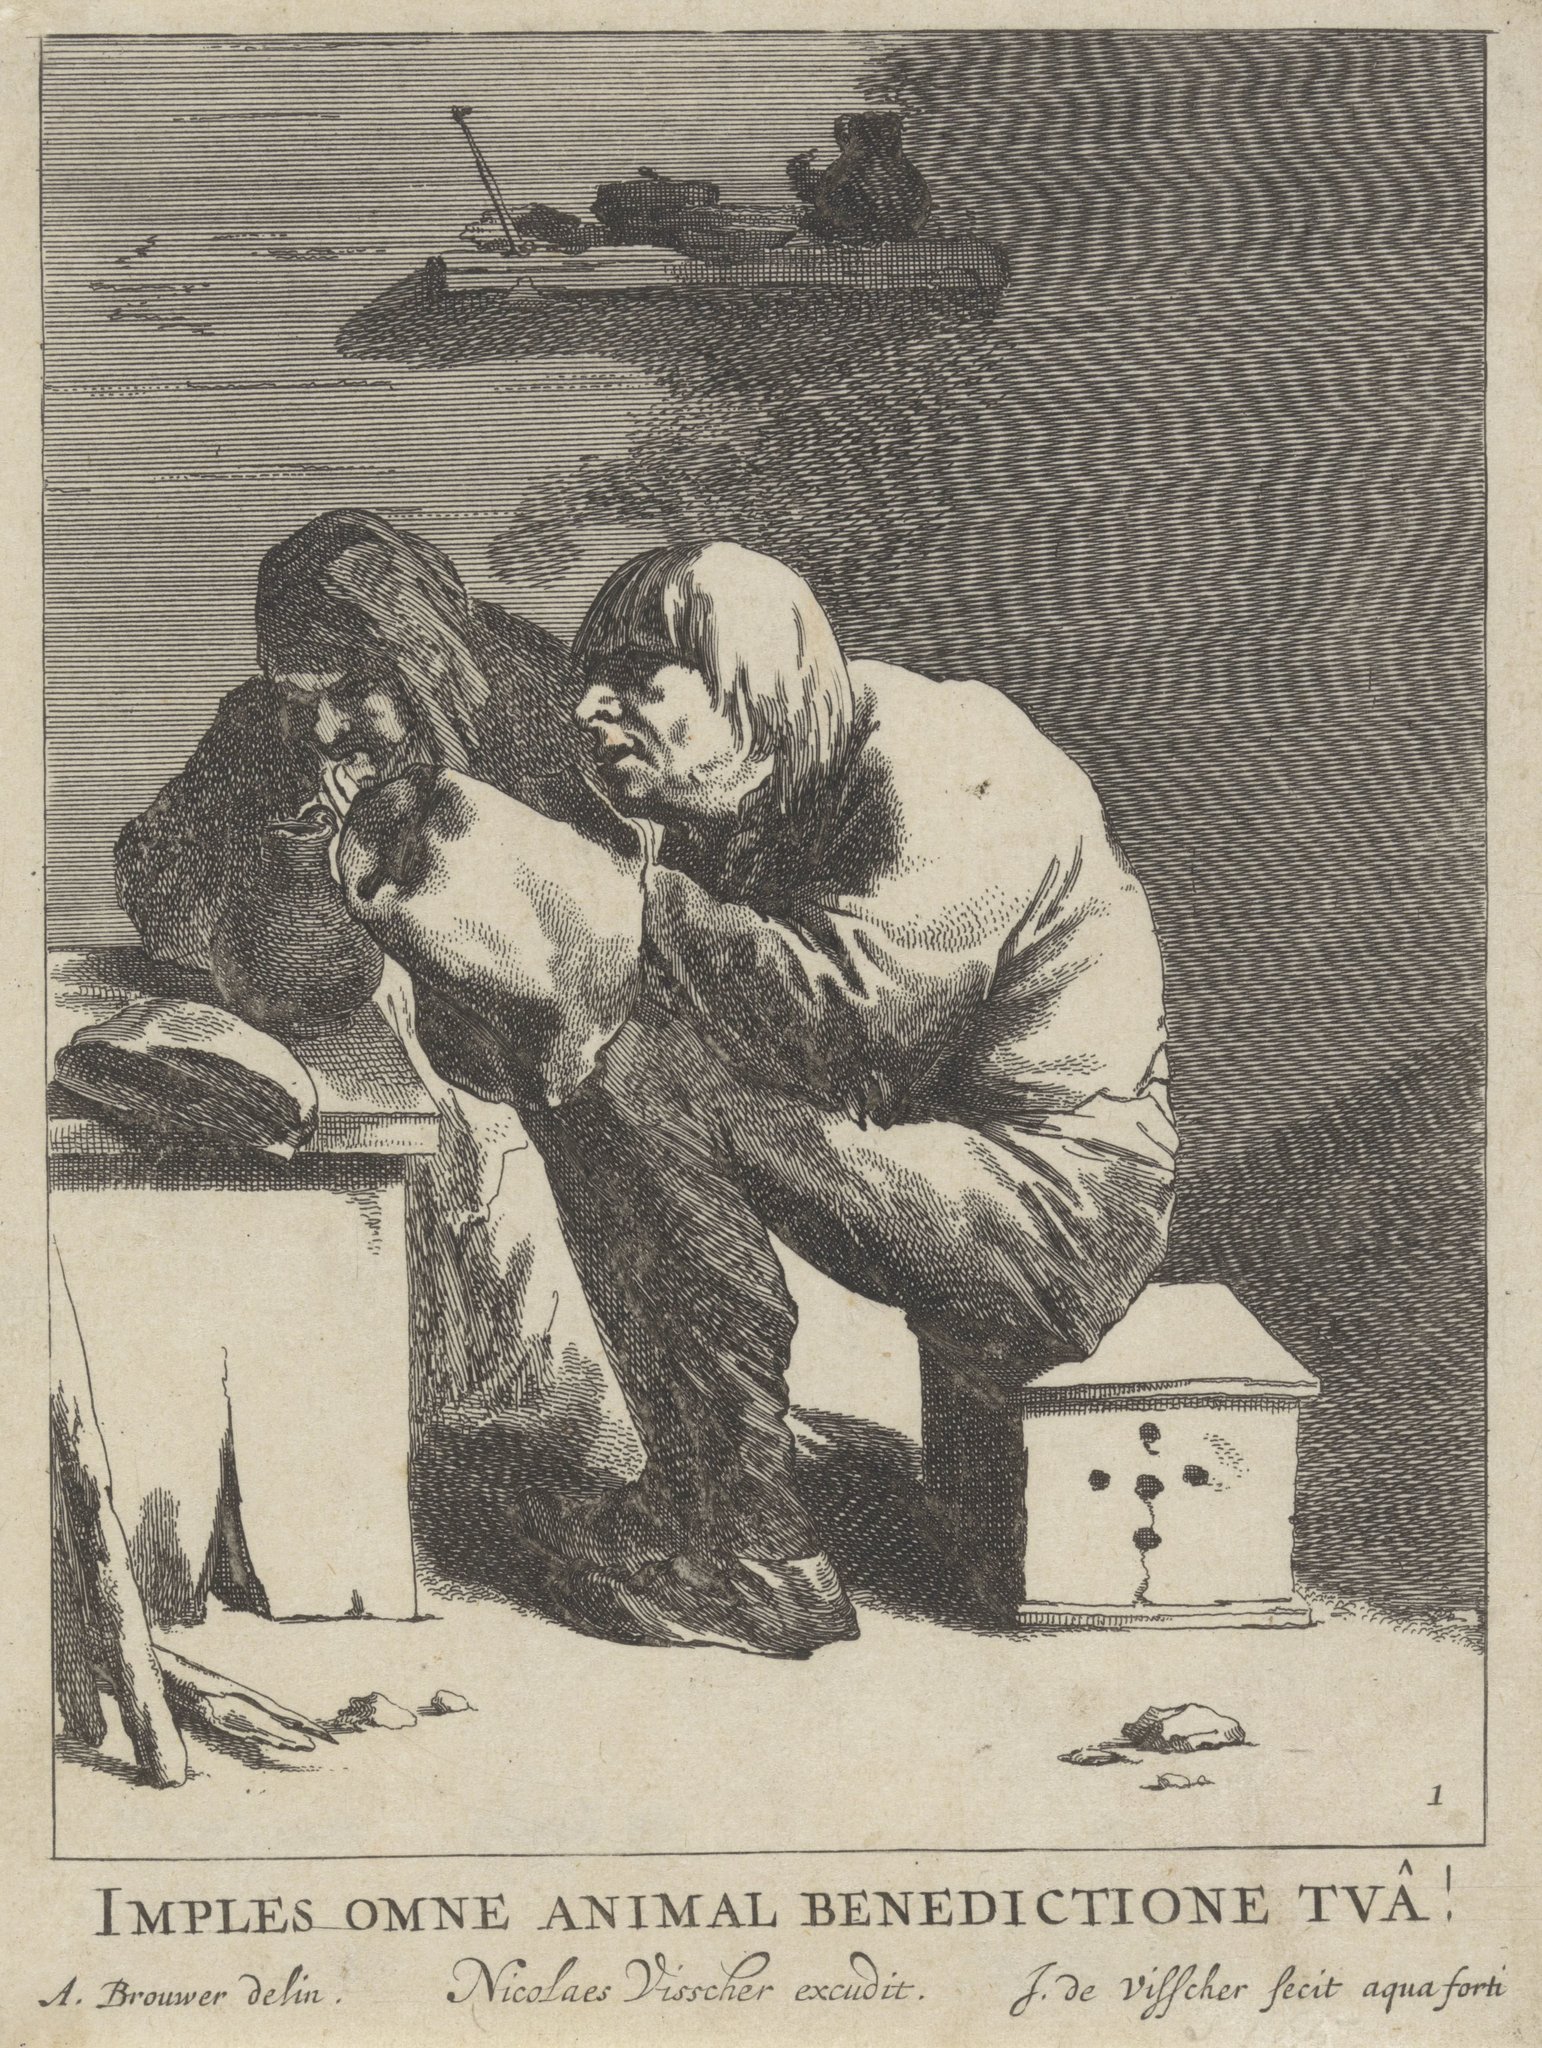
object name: print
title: Imples omne animal benedictione tva!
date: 1643-1709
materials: paper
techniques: etching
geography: amsterdam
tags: head-gear, foot-stove, prayer at table, saying grace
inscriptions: collector's mark: Lugt 240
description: In een eenvoudig interieur zitten twee figuren te bidden aan een tafel. De voorste figuur zit op een stoofje en heeft zijn hoed afgenomen.